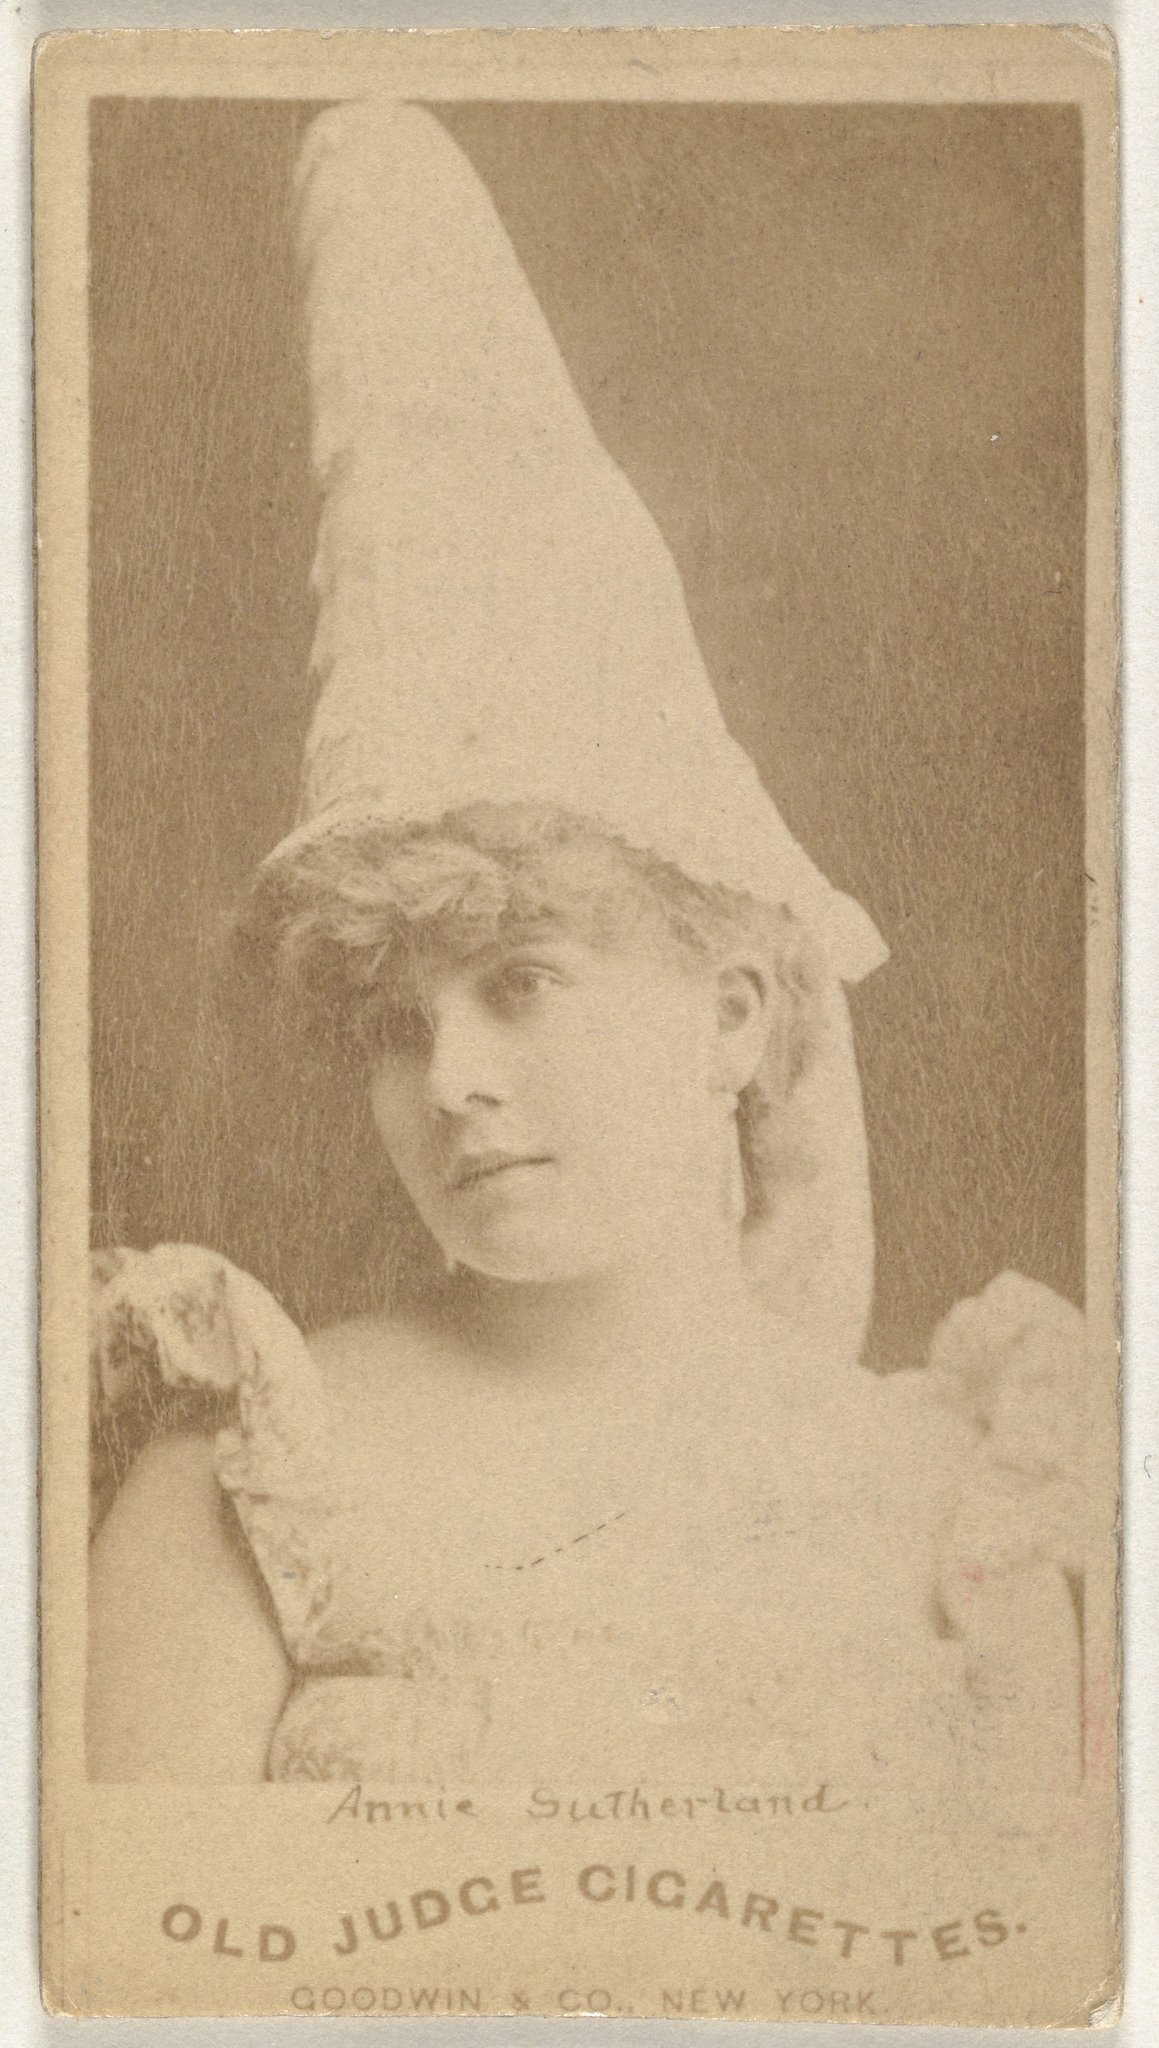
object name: photograph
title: Annie Sutherland, from the Actors and Actresses series (N171) for Old Judge Cigarettes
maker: goodwin & company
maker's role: publisher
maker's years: 1850-1950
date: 1886-1890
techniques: albumen silver print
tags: portraits,women,actresses